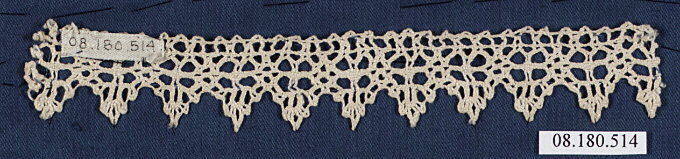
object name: fragment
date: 1501-1600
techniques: lace